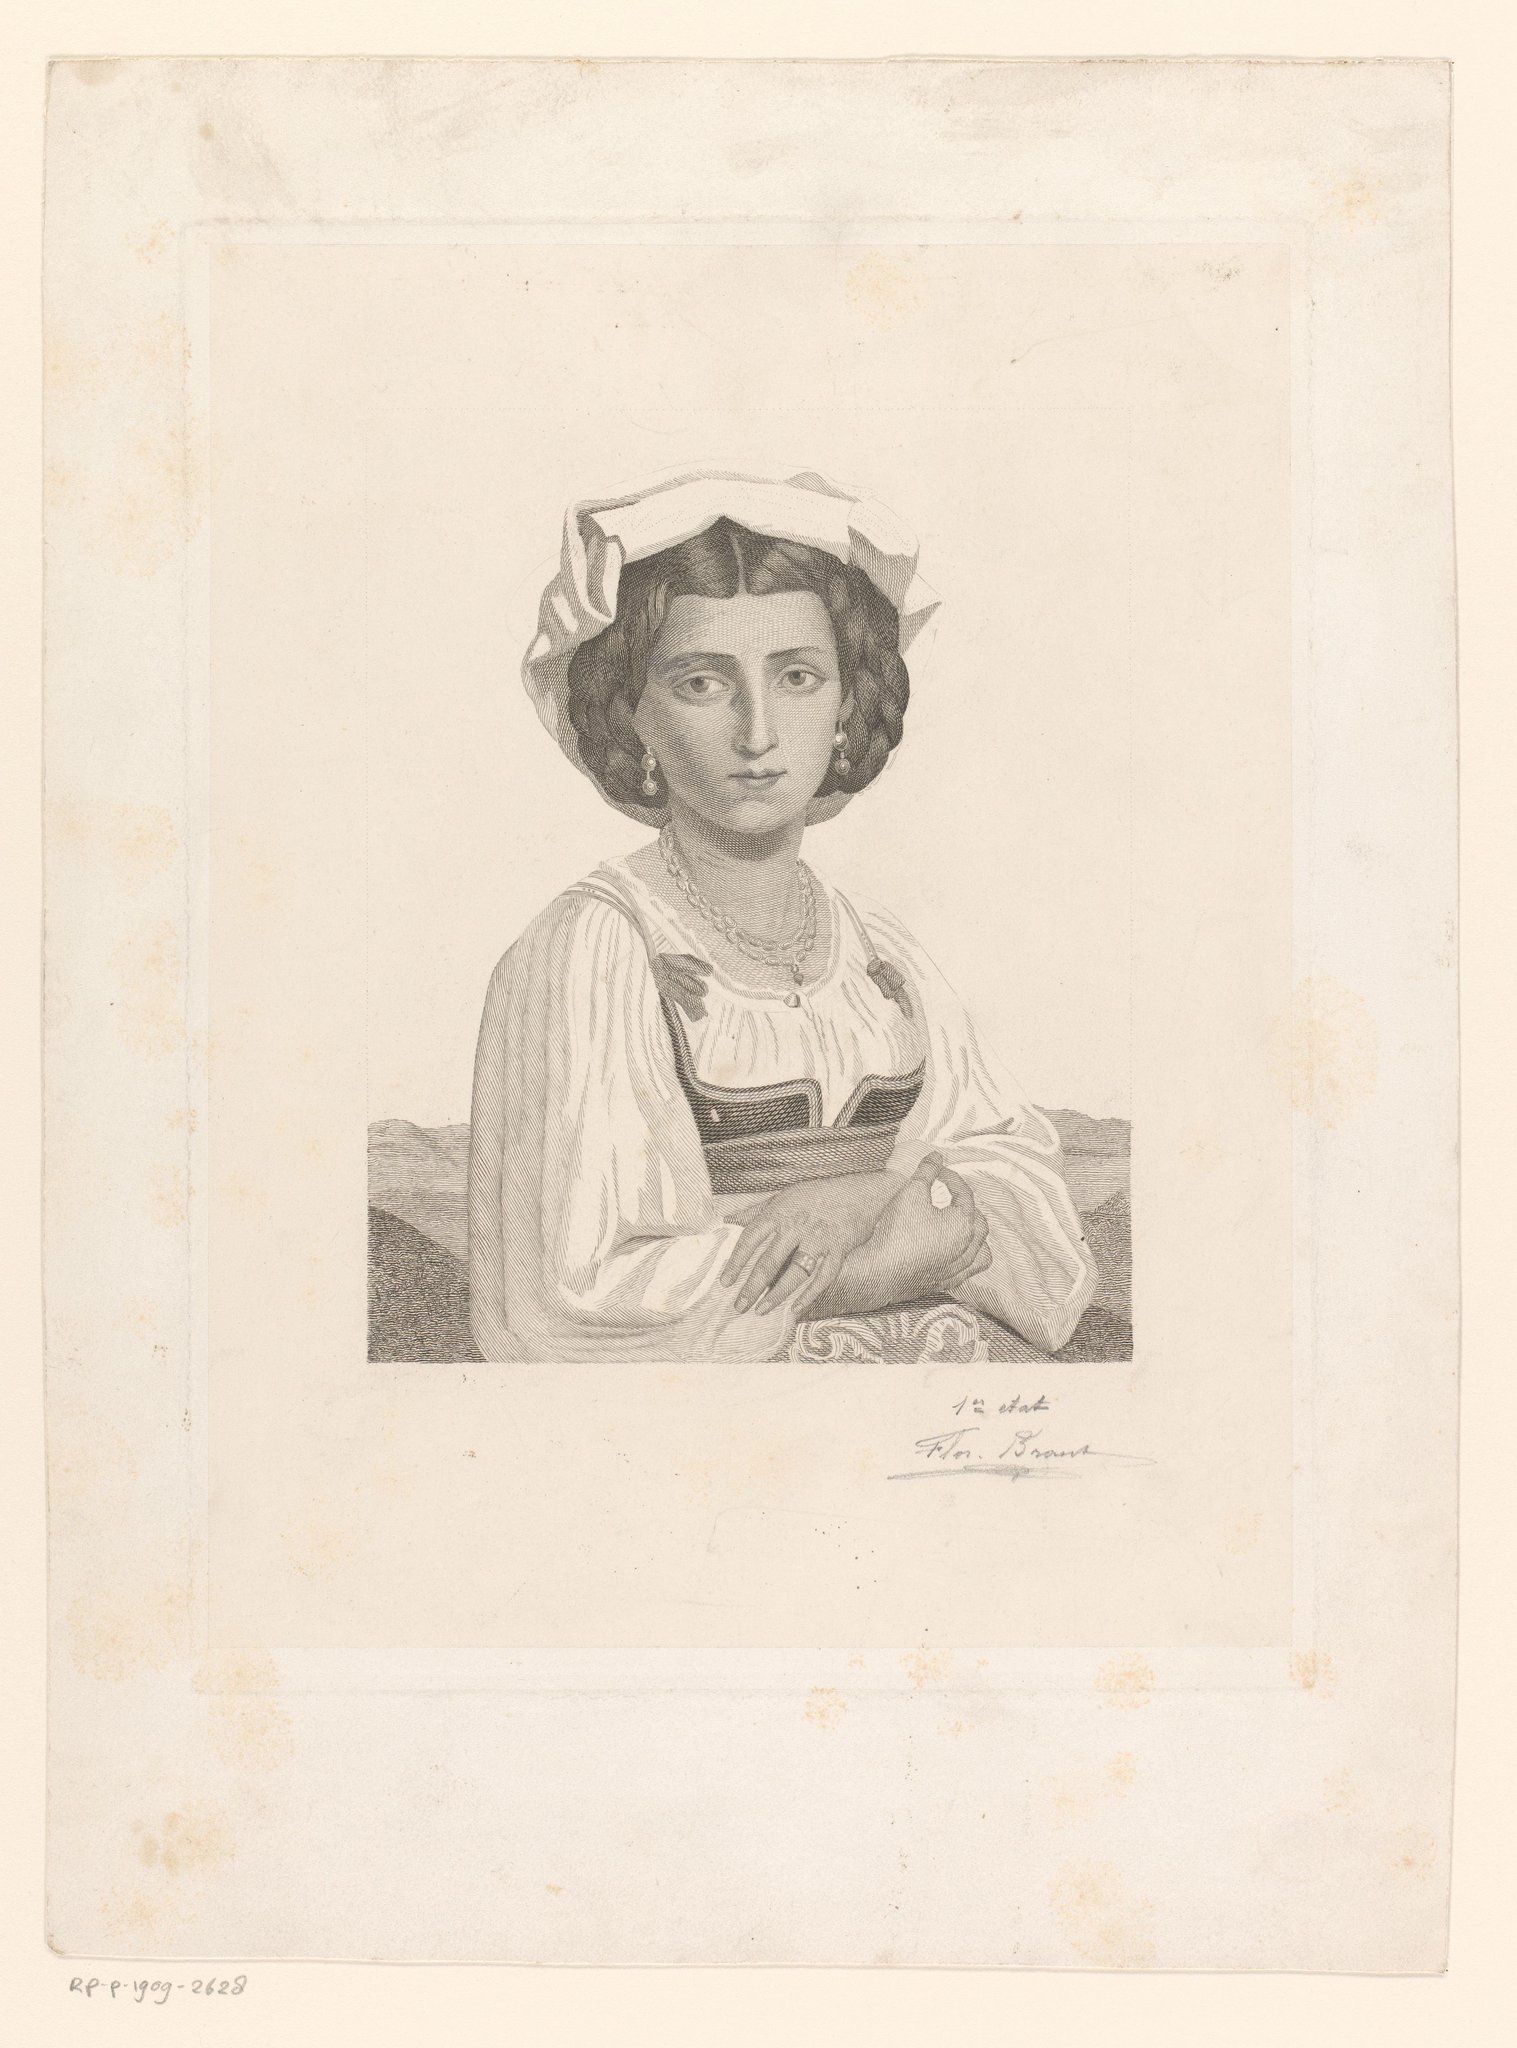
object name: print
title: Portret van een onbekende Italiaanse vrouw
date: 1873-1909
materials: paper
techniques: engraving, etching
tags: adult woman, historical persons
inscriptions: inscription: ‘1e etat’, collector's mark: Lugt 2228